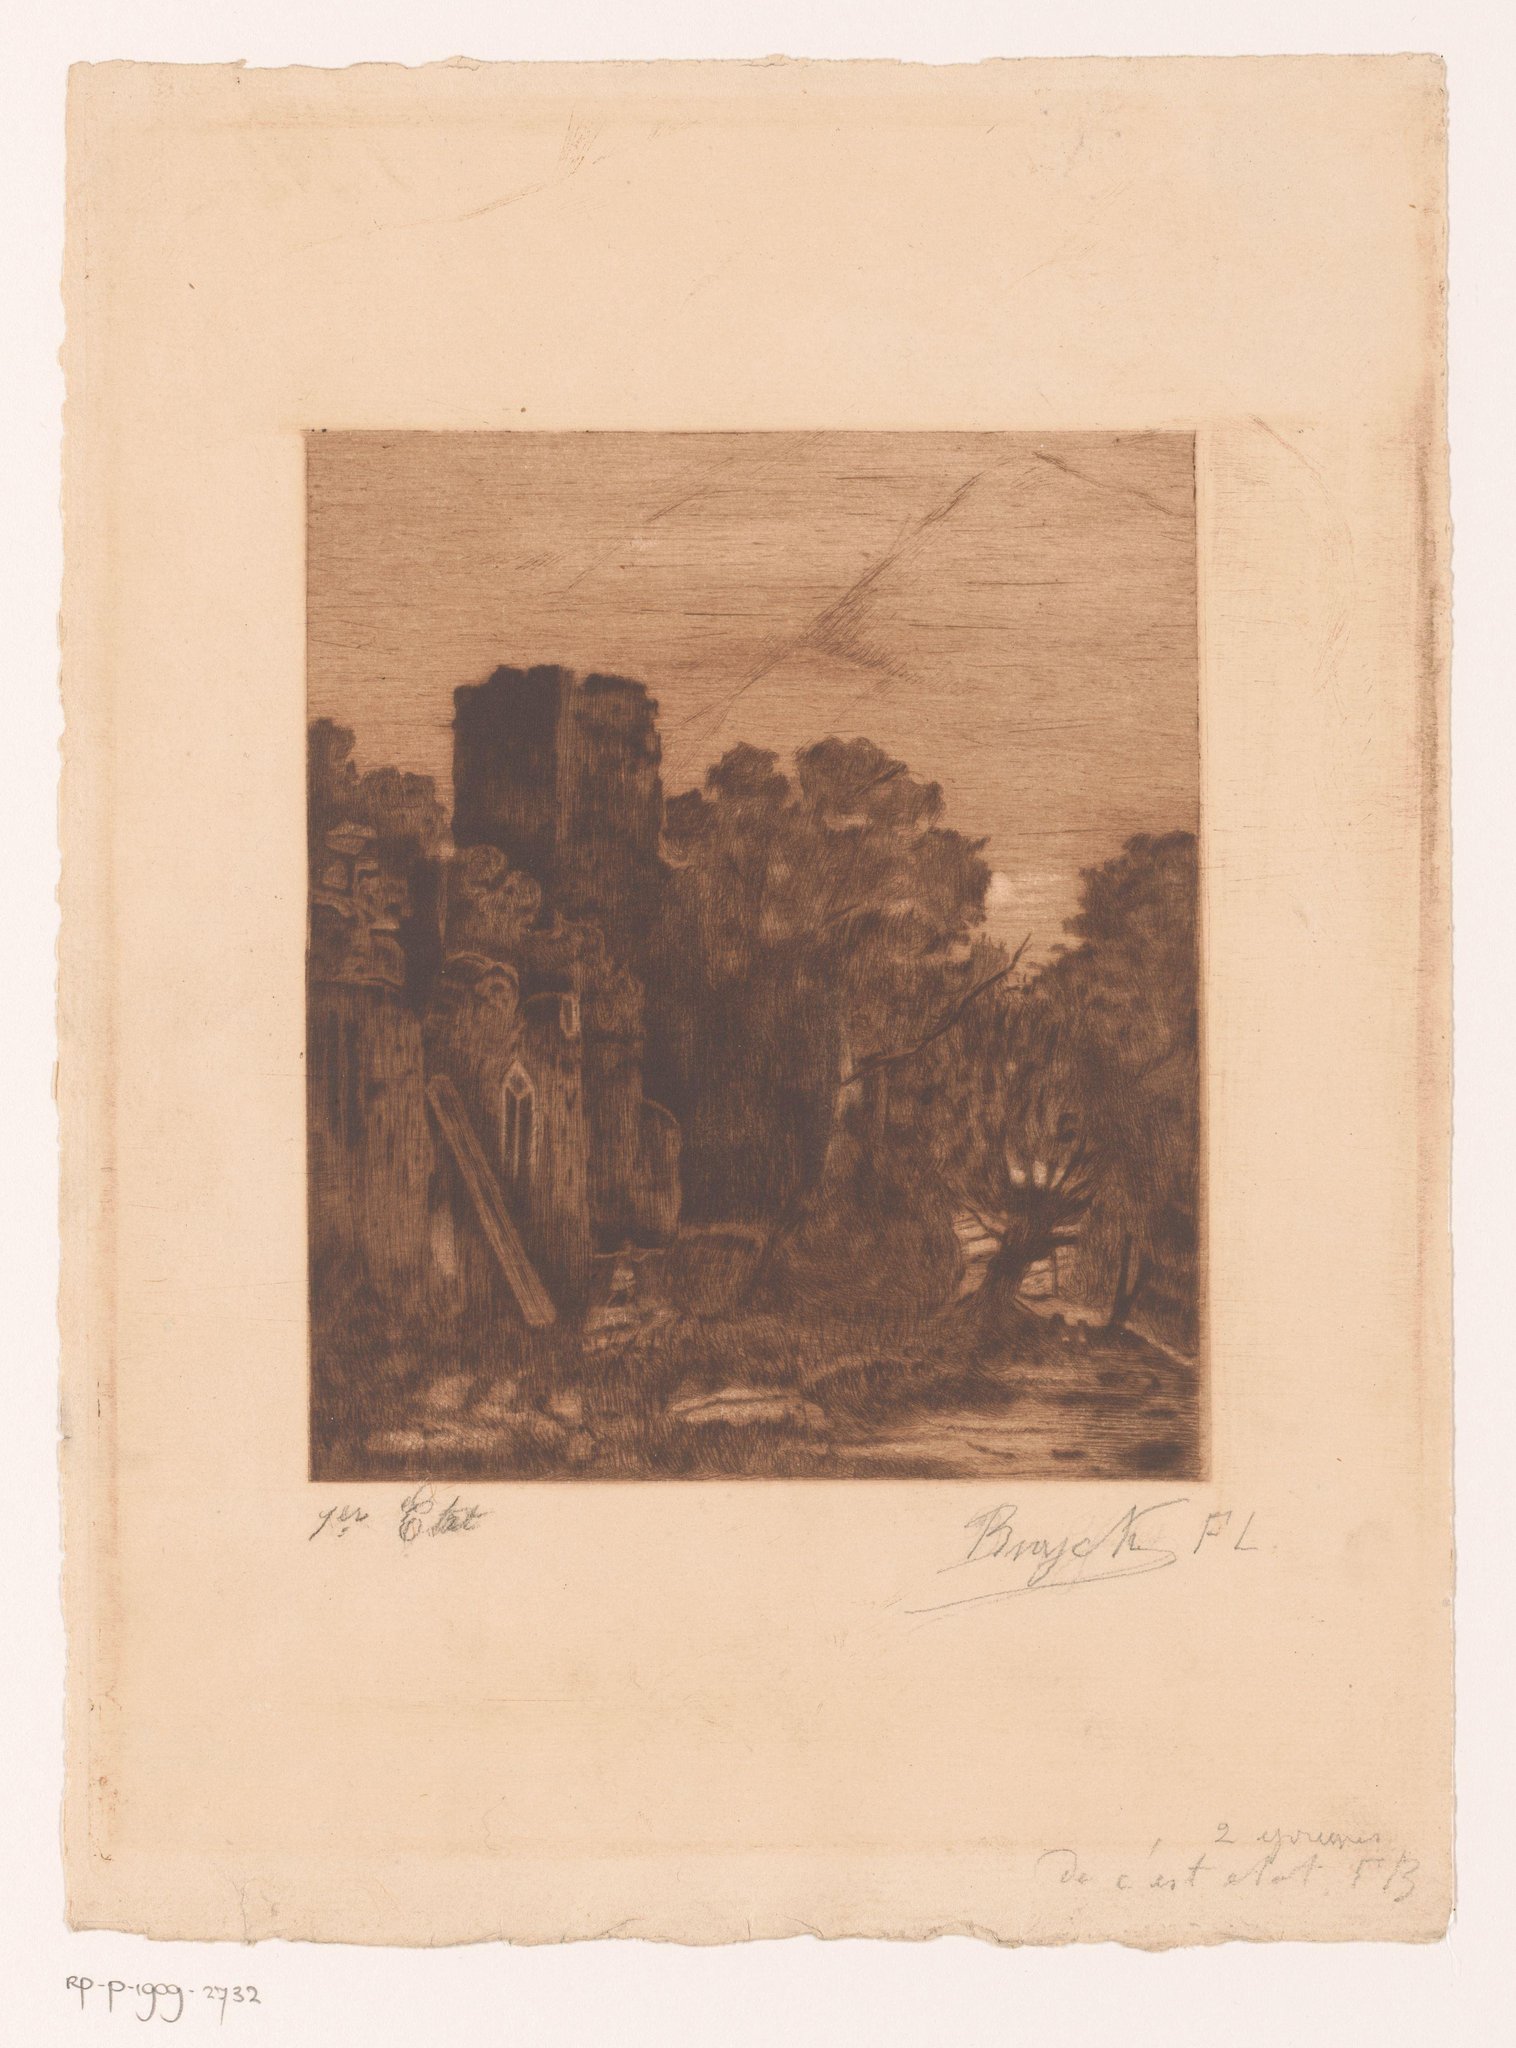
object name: print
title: Landschap met kasteelruïne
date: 1870-1909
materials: paper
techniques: drypoint, etching, intaglio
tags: ruin of a dwelling, house, castle, etc.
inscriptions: annotation: ‘1et Etat’, annotation: ‘2 epreuves de c'est etat’, collector's mark: Lugt 2228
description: Sterfdatum prentmaker onbekend. Derhalve is voor bepaling van de rechten van dit object de verwervingsdatum aangehouden.